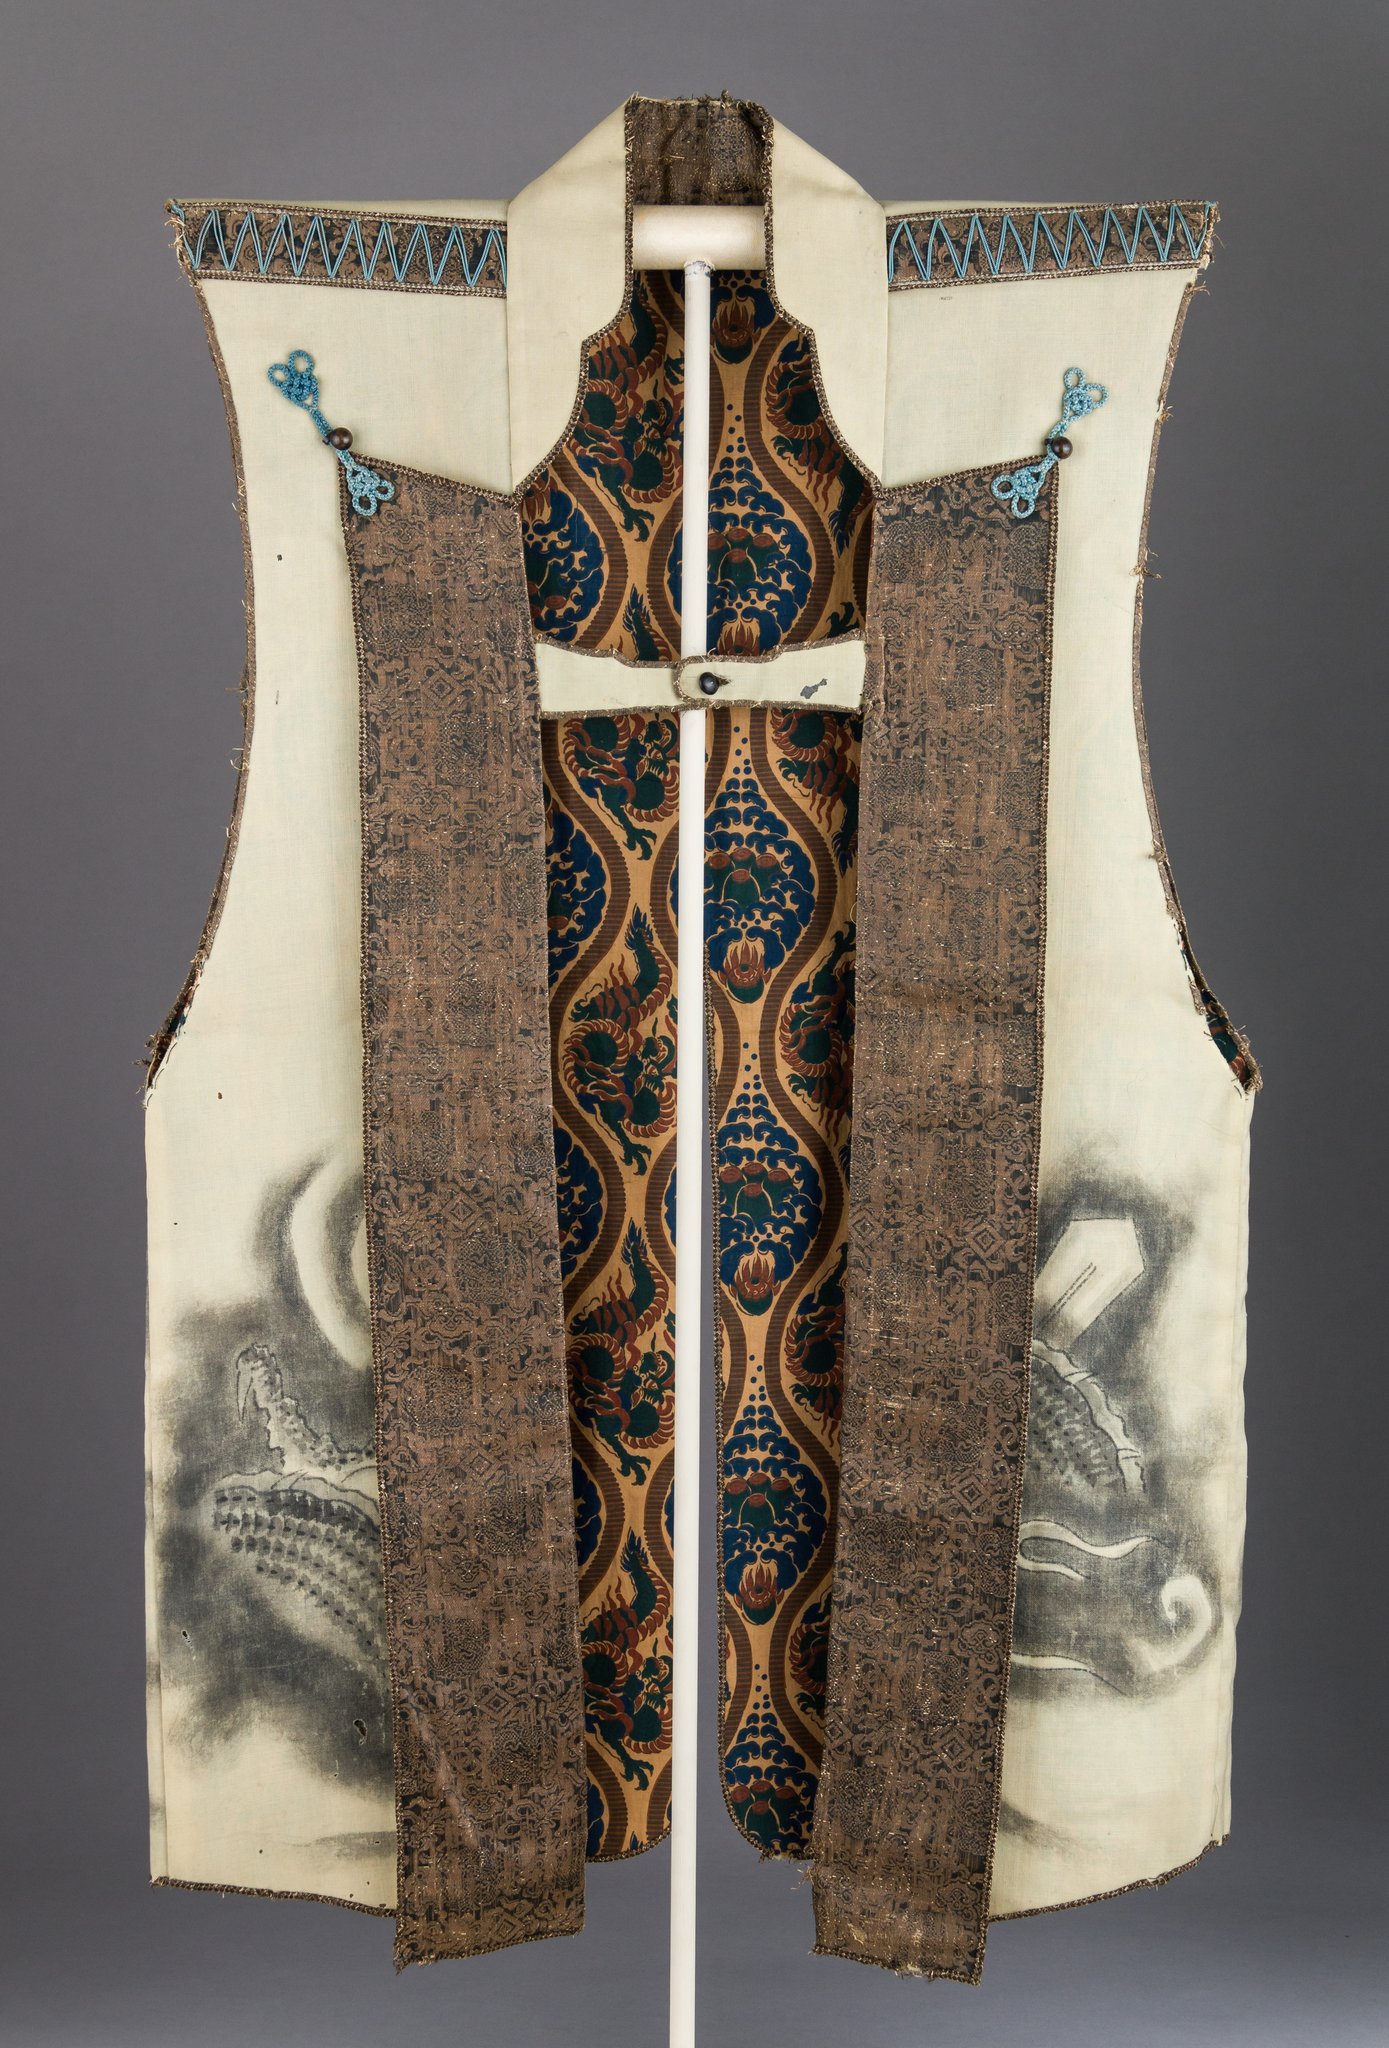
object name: surcoat i jinbaori i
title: Surcoat (Jinbaori)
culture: japanese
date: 1701-1800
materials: cotton, linen, pigment, silk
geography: japan